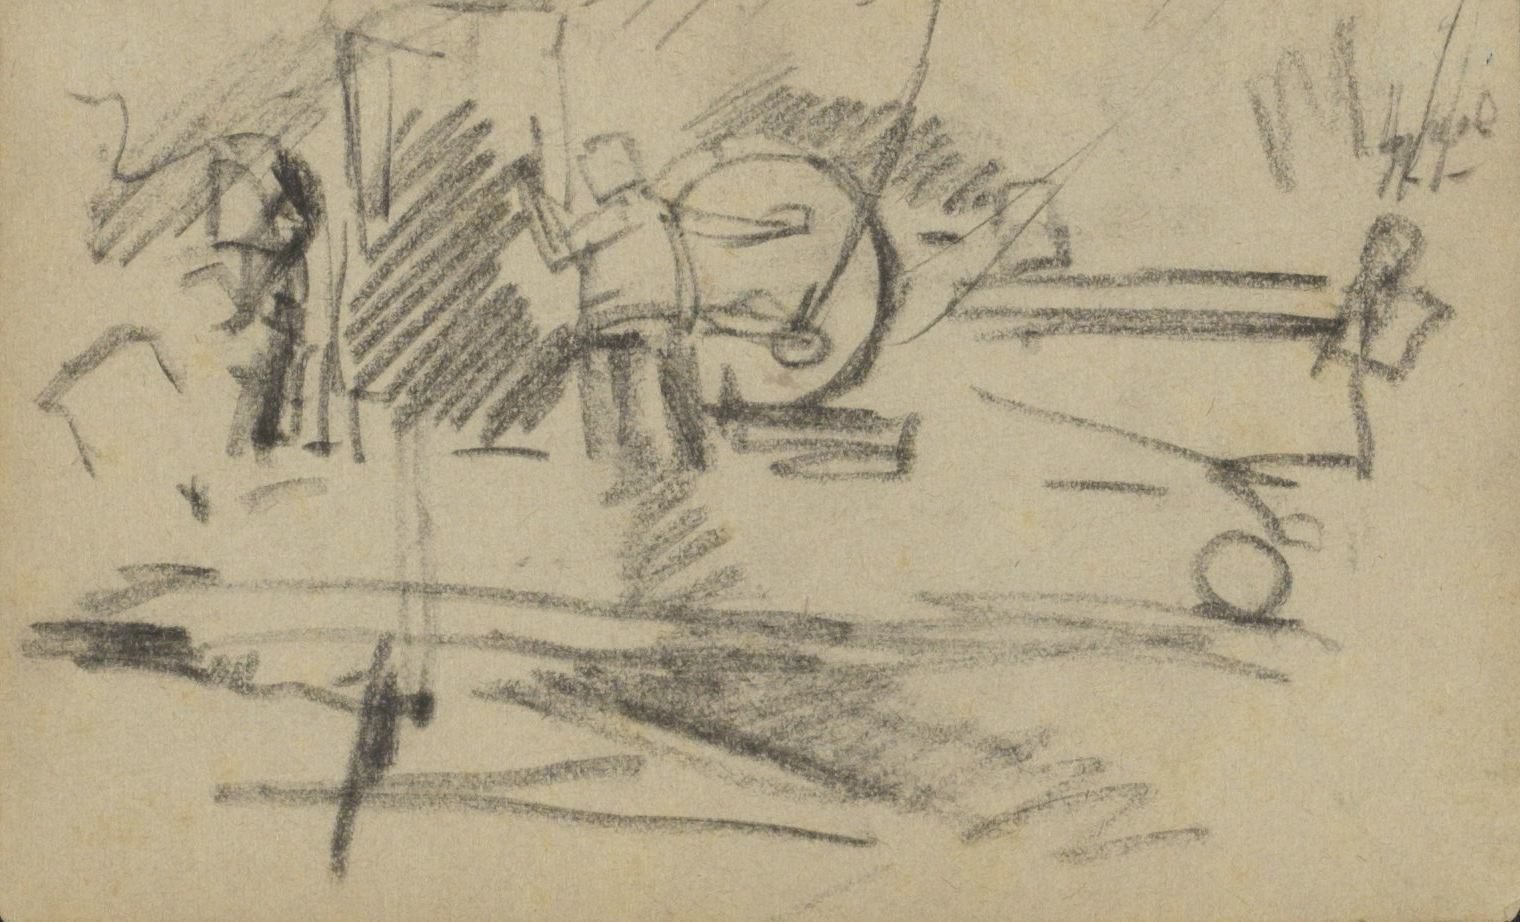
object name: drawing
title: Man, mogelijk in een werkplaats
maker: george hendrik breitner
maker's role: draughtsman, painter, print maker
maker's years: 1857-1923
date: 1887-1891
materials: chalk, paper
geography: gelderland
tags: factory-interior, machine shop (+ labourers ~ crafts, industries, agriculture)